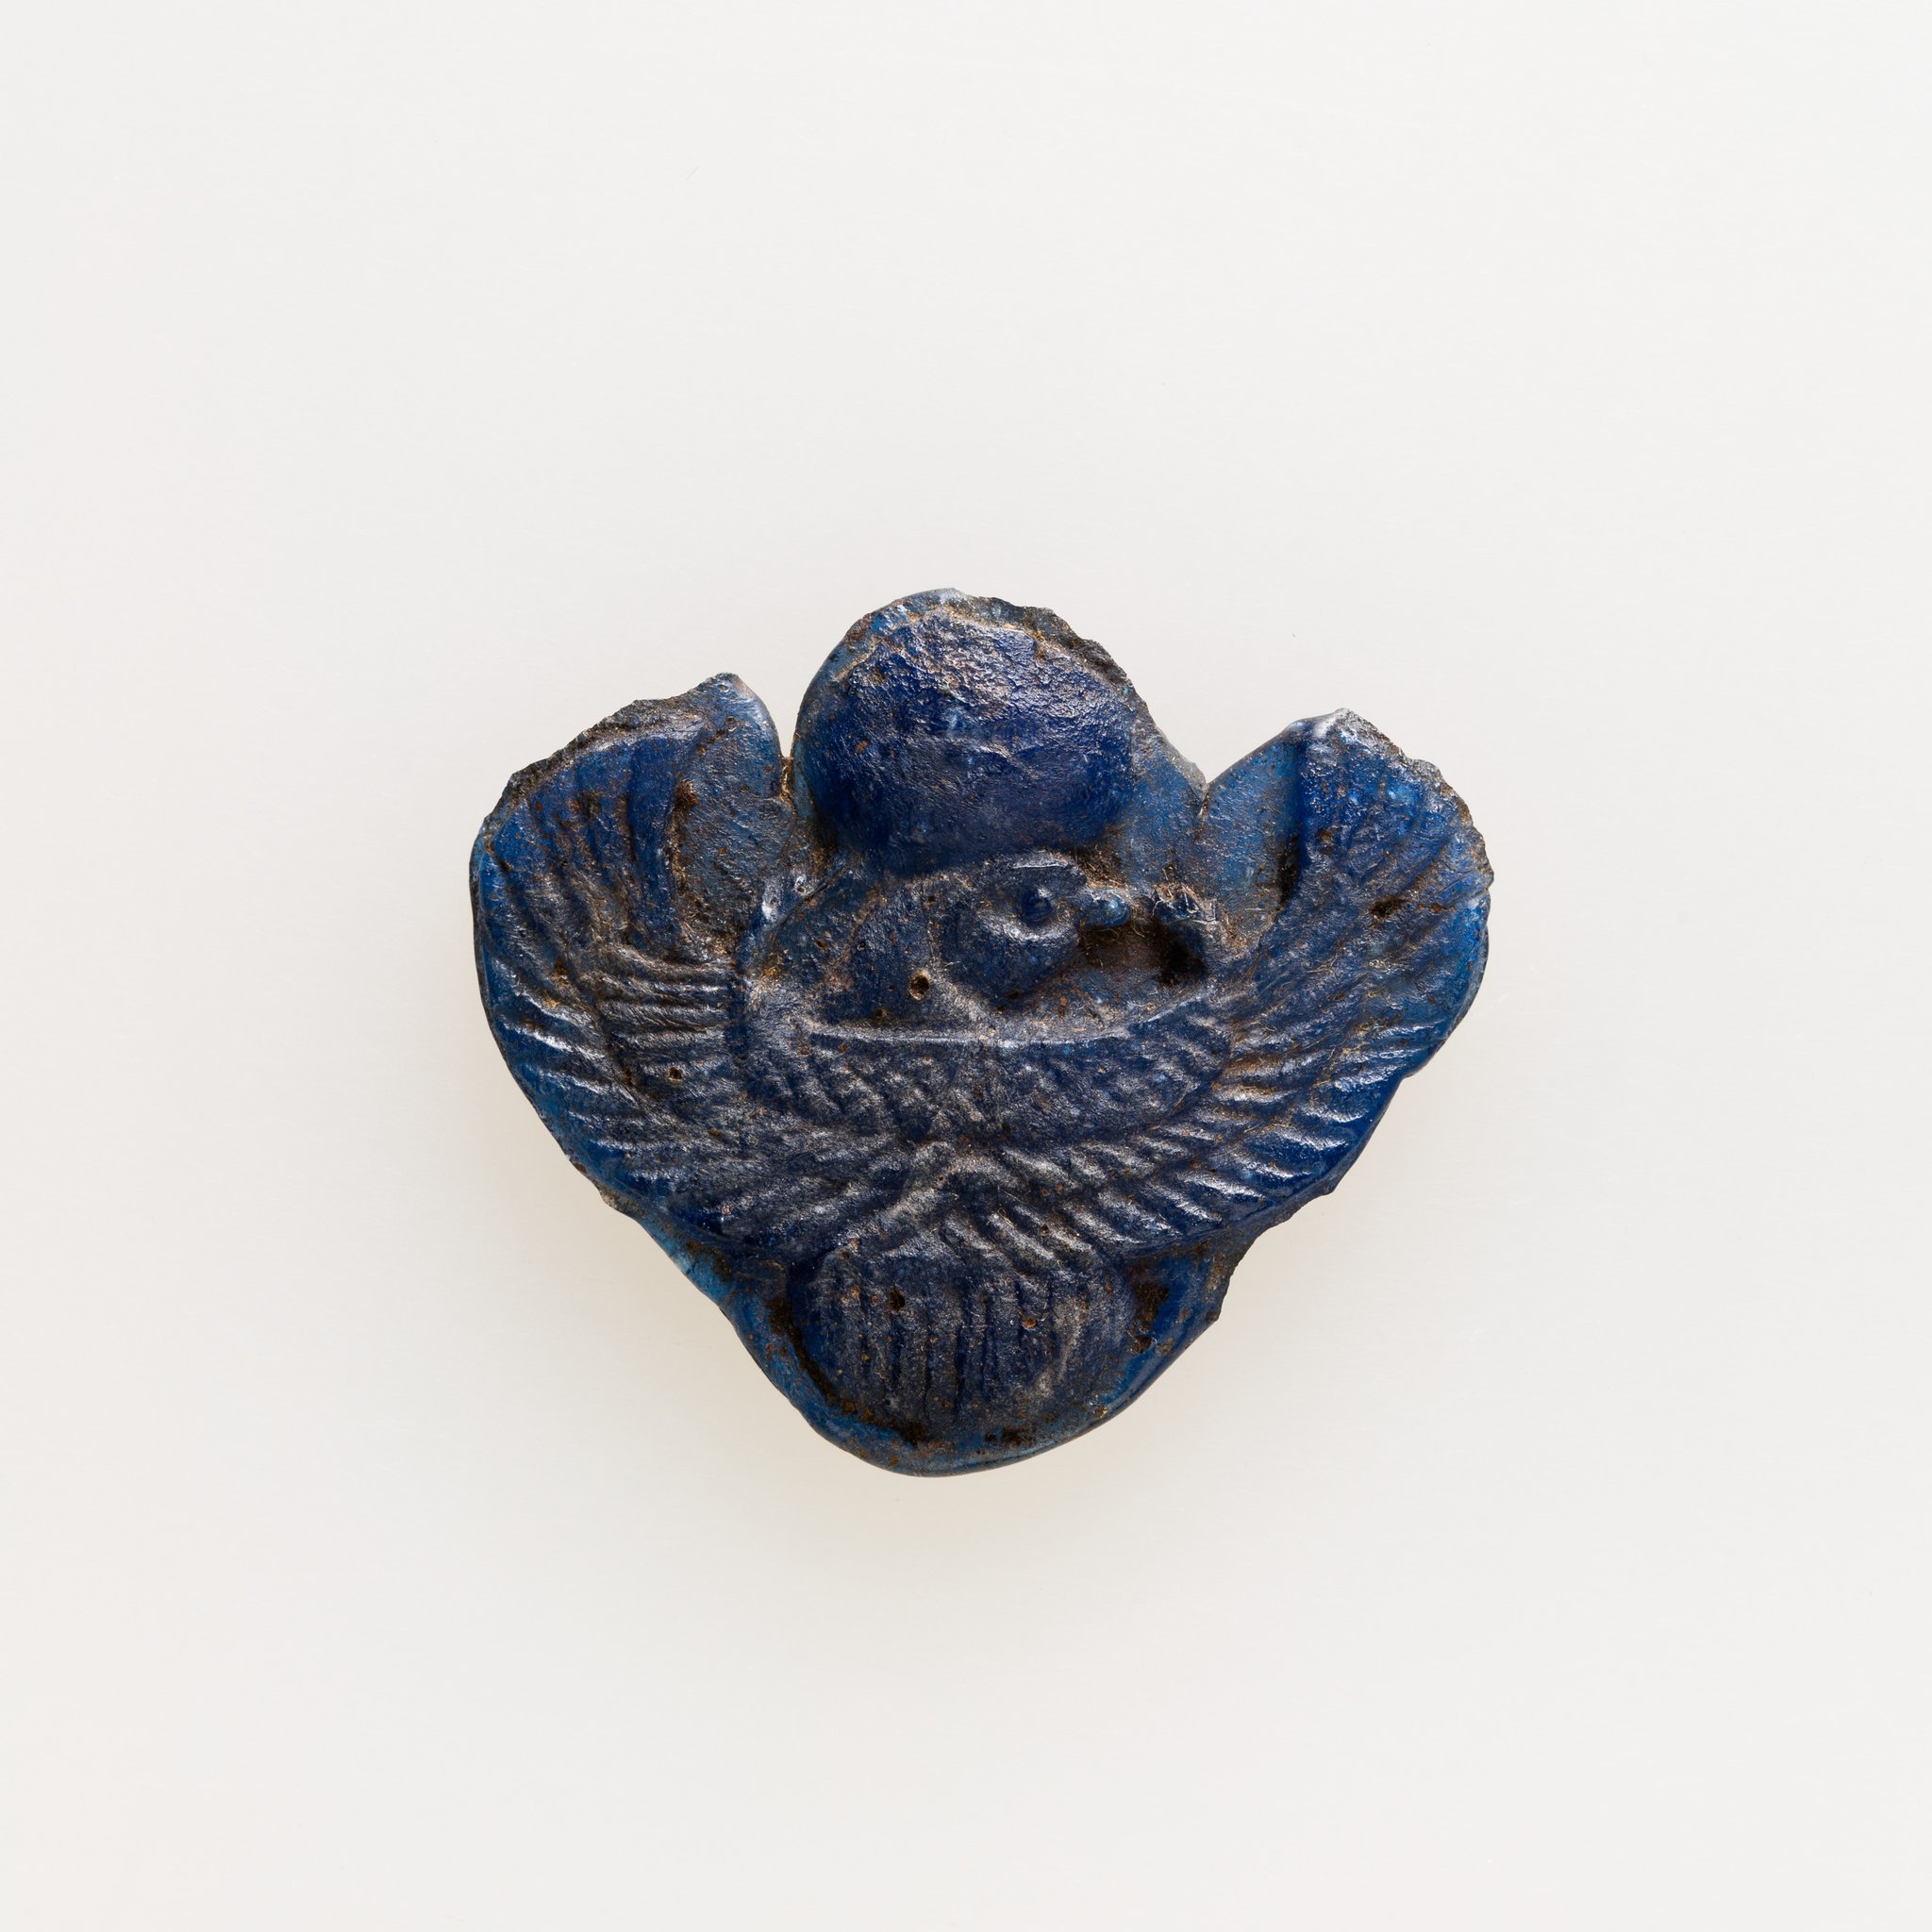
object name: amulet, winged scarab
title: Amulet of winged scarab with falcon head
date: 525-30 BCE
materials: glass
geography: egypt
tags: falcons,scarabs